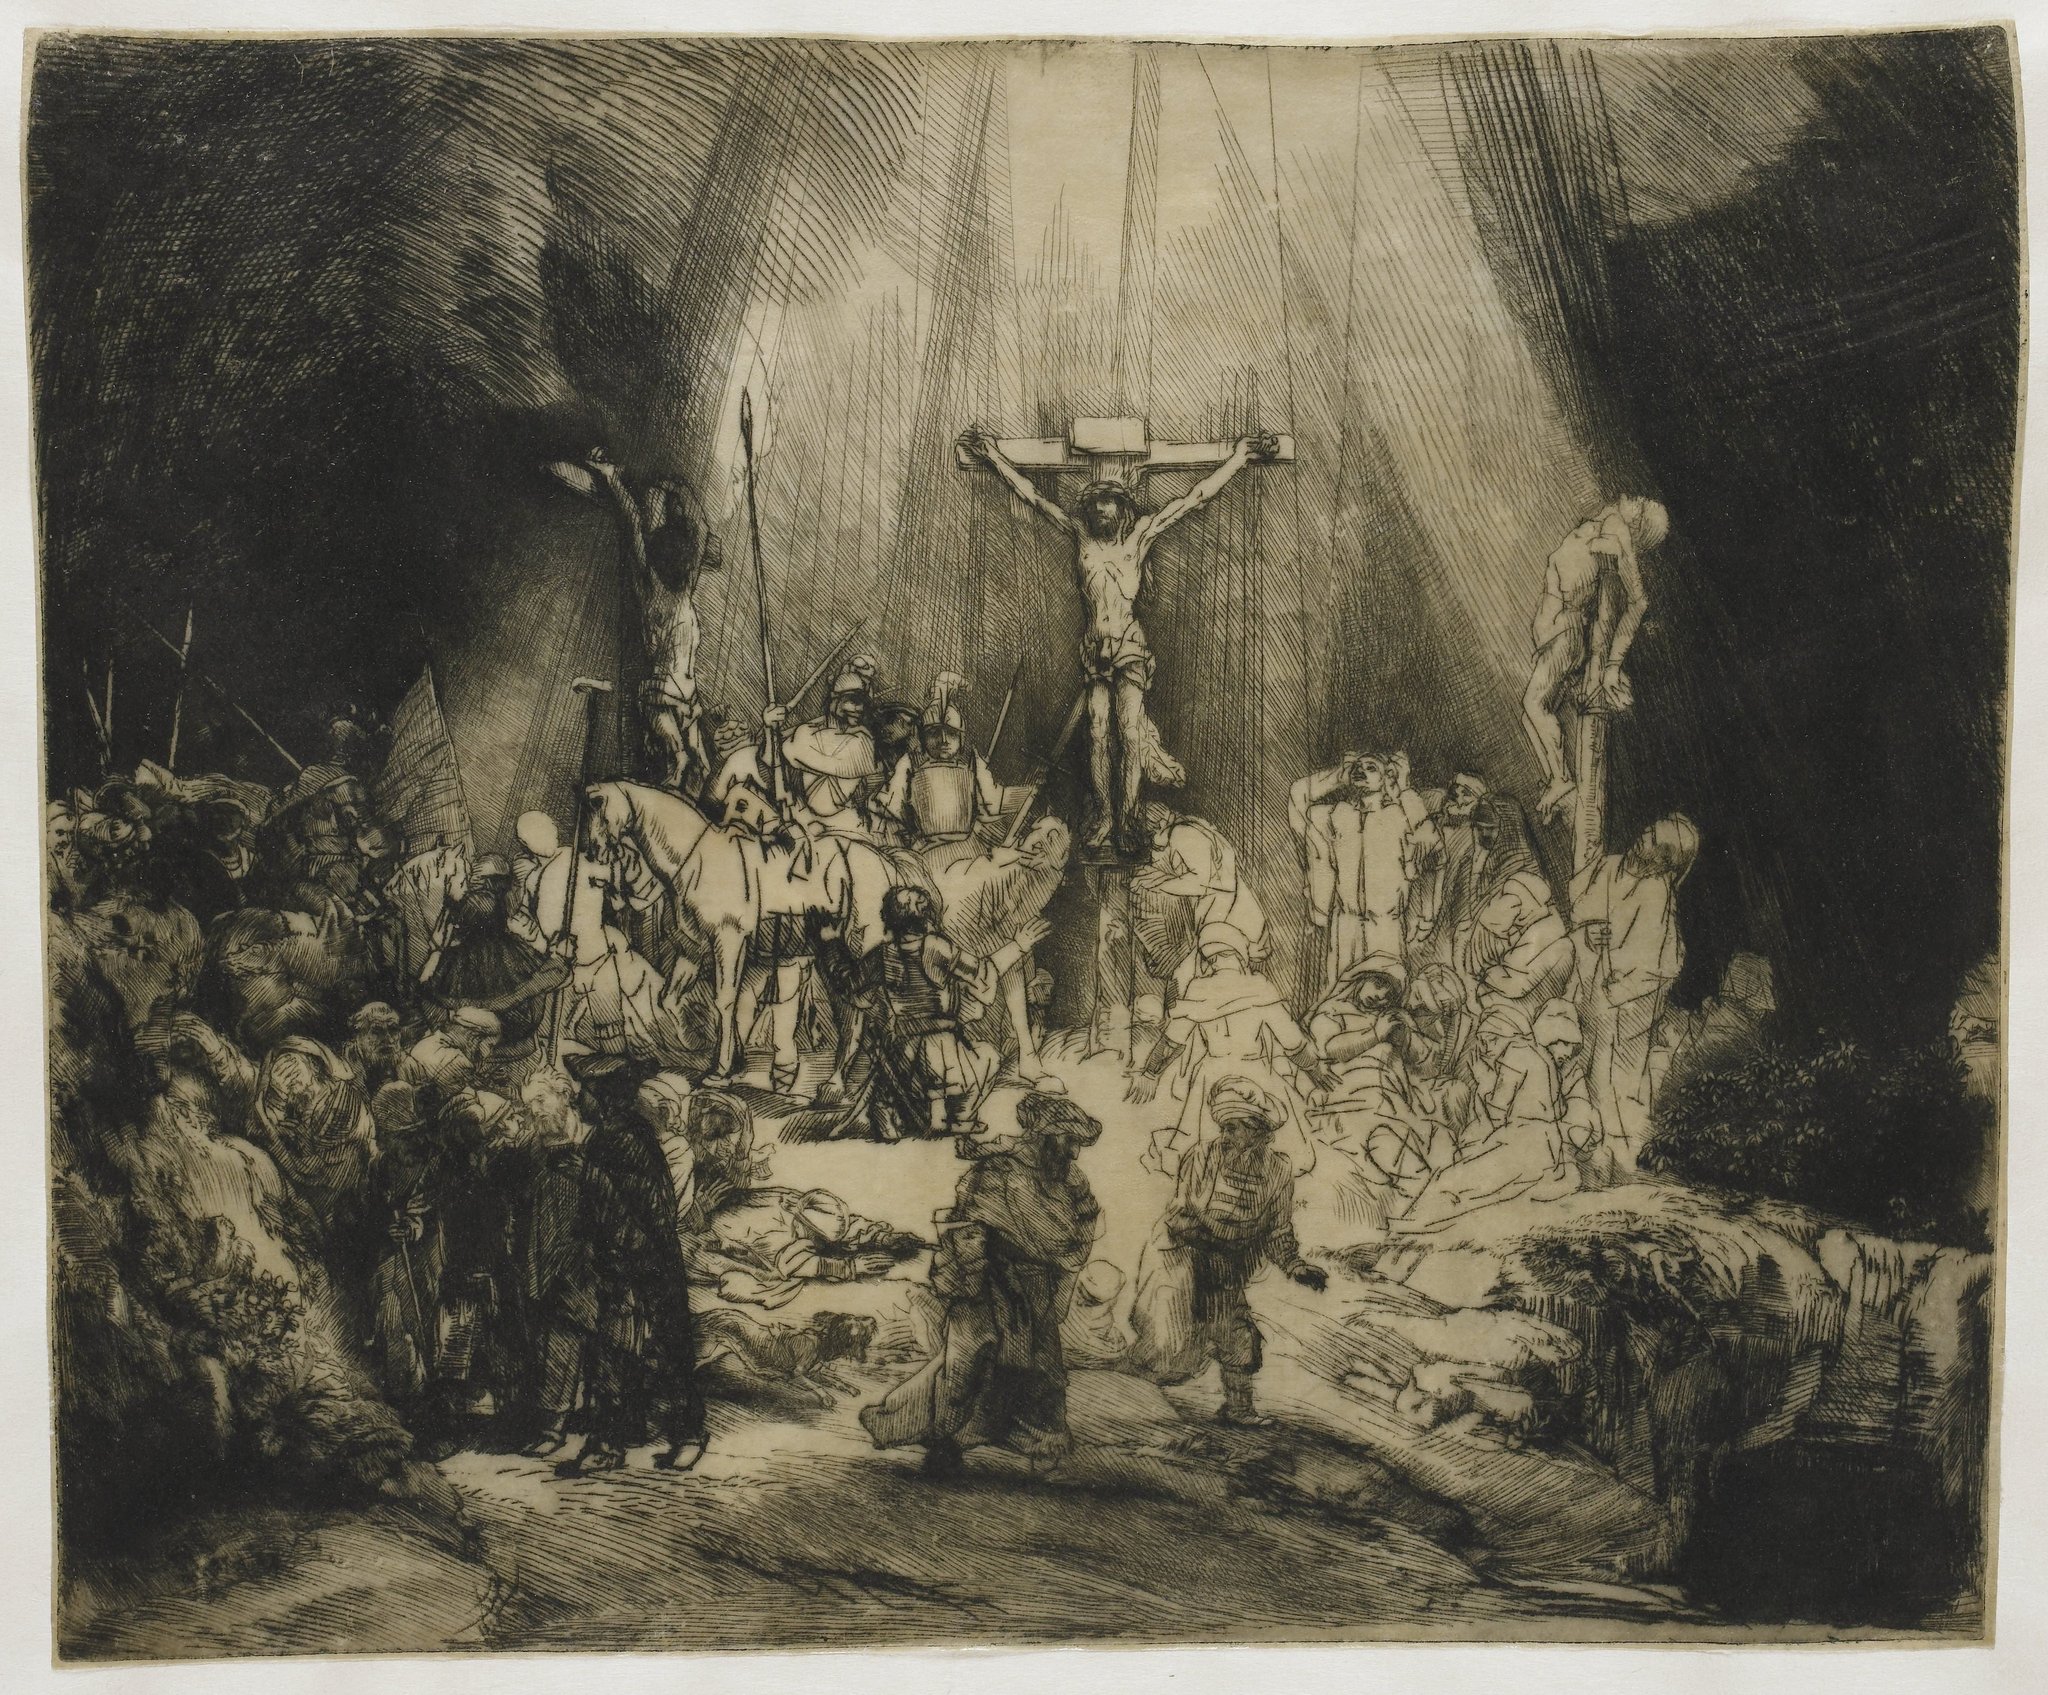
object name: print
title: Christ Crucified between the two Thieves: 'The Three Crosses'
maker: rembrandt van rijn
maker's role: draughtsman, painter, print maker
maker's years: 1606-1669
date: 1653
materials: parchment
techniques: drypoint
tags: the crucifixion of christ: prelude to christ's death on the cross (matthew 27:34-44; mark 15:23-32; luke 23:33-43; john 19:18-24)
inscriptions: collector's mark: Lugt 2228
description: Christ hangs from the Cross between two thieves and is surrounded by apostles, his mother, followers and soldiers. This monumental sheet is the pendant to Christ Presented to the People (on the opposite partition wall). Just as there, this scene is fully executed in drypoint, which had almost never been done before. Moreover, Rembrandt pulled the print on costly vellum.